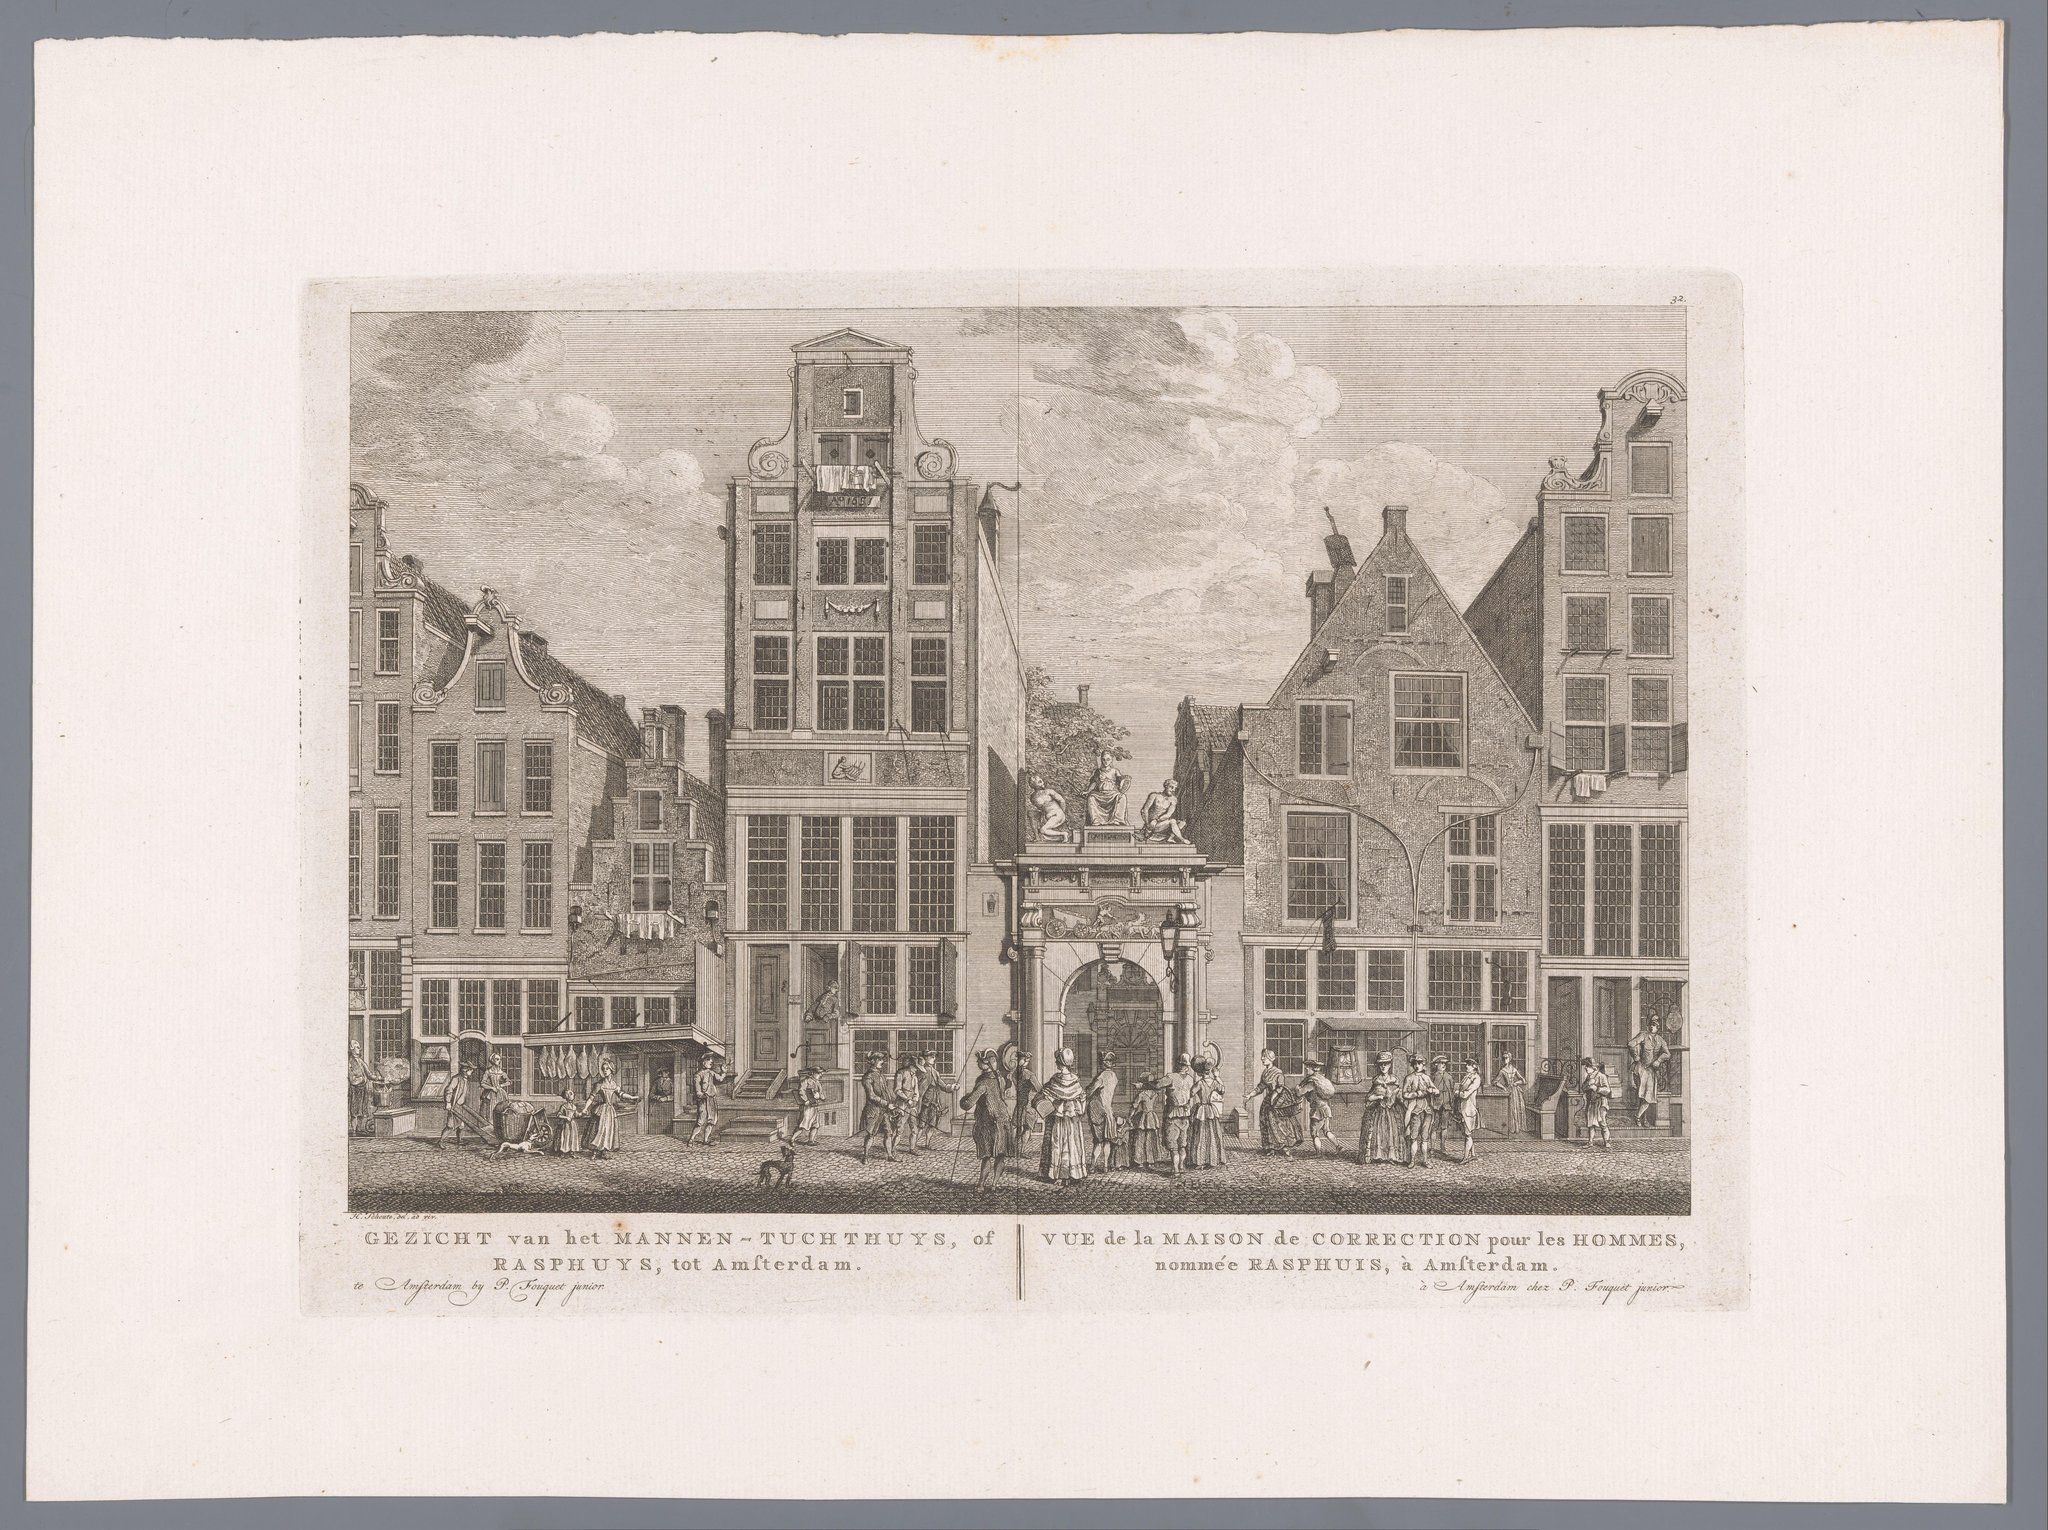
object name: print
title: Atlas van Fouquet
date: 1770-1783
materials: paper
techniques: etching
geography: amsterdam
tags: prison, jail, workhouse, penal camp, penitentiary, chain gang, street (+ city(-scape) with figures, staffage)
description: Vanaf 1760 gaf Pierre Fouquet stadsgezichten van Amsterdam naar tekeningen van verschillende kunstenaars uit. Deze prenten werden aanvankelijk los verkocht. Later werden ze samengebonden verkocht in verschillende volgordes en aantallen in: (1). Afbeeldingen van de wyd-vermaarde koopstad Amsterdam benevens des zelvs voornaamste gebouwen en gezigten alle naar het leeven getekend / Receuil des edifices les plus considerables et des plus belles vues, de la fameuse ville d'Amsterdam, dessinées d'après nature. Amsterdam: Pierre Fouquet, 1778-1783. Deze 'uitgave' bestond waarschijnlijk alleen uit een titelblad en inhoudsopgave van de tot dusver 100 uitgegeven prenten, die de koper zelf aan zijn of haar reeds verzamelde prenten kon toevoegen. De hoeveelheid en volgorde van prenten verzameld onder deze titel verschilt dus sterk. (2). Nieuwe atlas, van de voornaamste gebouwen en gezigten der stad Amsterdam, met derzelver beknopte beschryvingen. 2 dln. Amsterdam: Daniël Jean Changuion en Petrus den Hengst [in opdracht van Pierre Fouquet], 1783. Ook werden er door verschillende uitgevers tussen 1788 (Amsterdam: Petrus Conradi) en 1805 (Amsterdam: Evert Maaskamp) heruitgaven gepubliceerd.